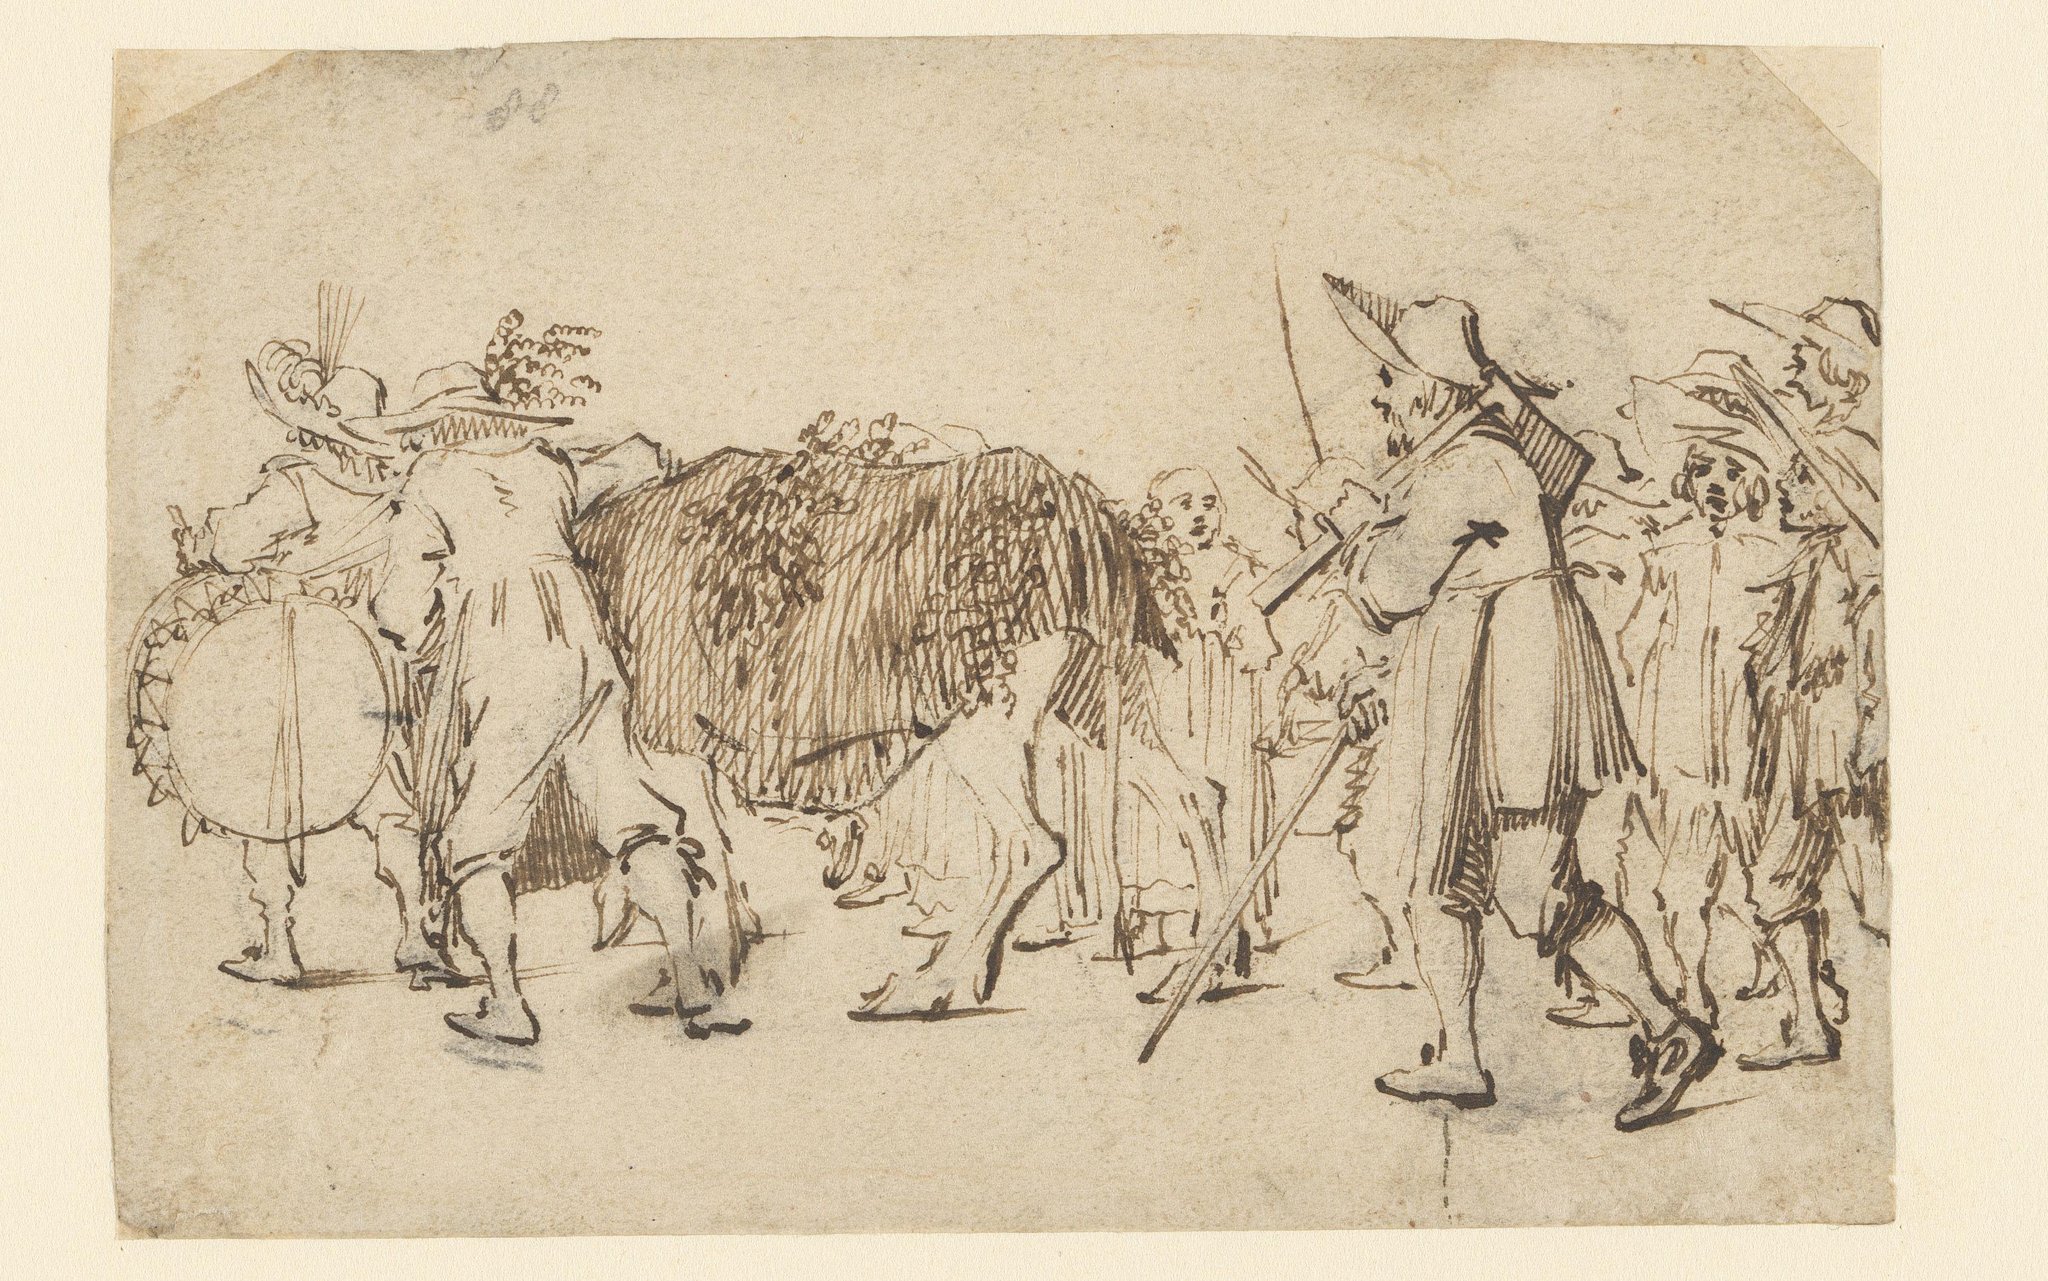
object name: drawing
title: Processie met een versierde os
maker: gerard ter borch (ii)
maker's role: draughtsman, painter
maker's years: 1617-1681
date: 1634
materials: chalk, ink, paper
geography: zwolle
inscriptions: date: ‘de.4. feberuarij 1634’, annotation: ‘86 [of '80' ?]’